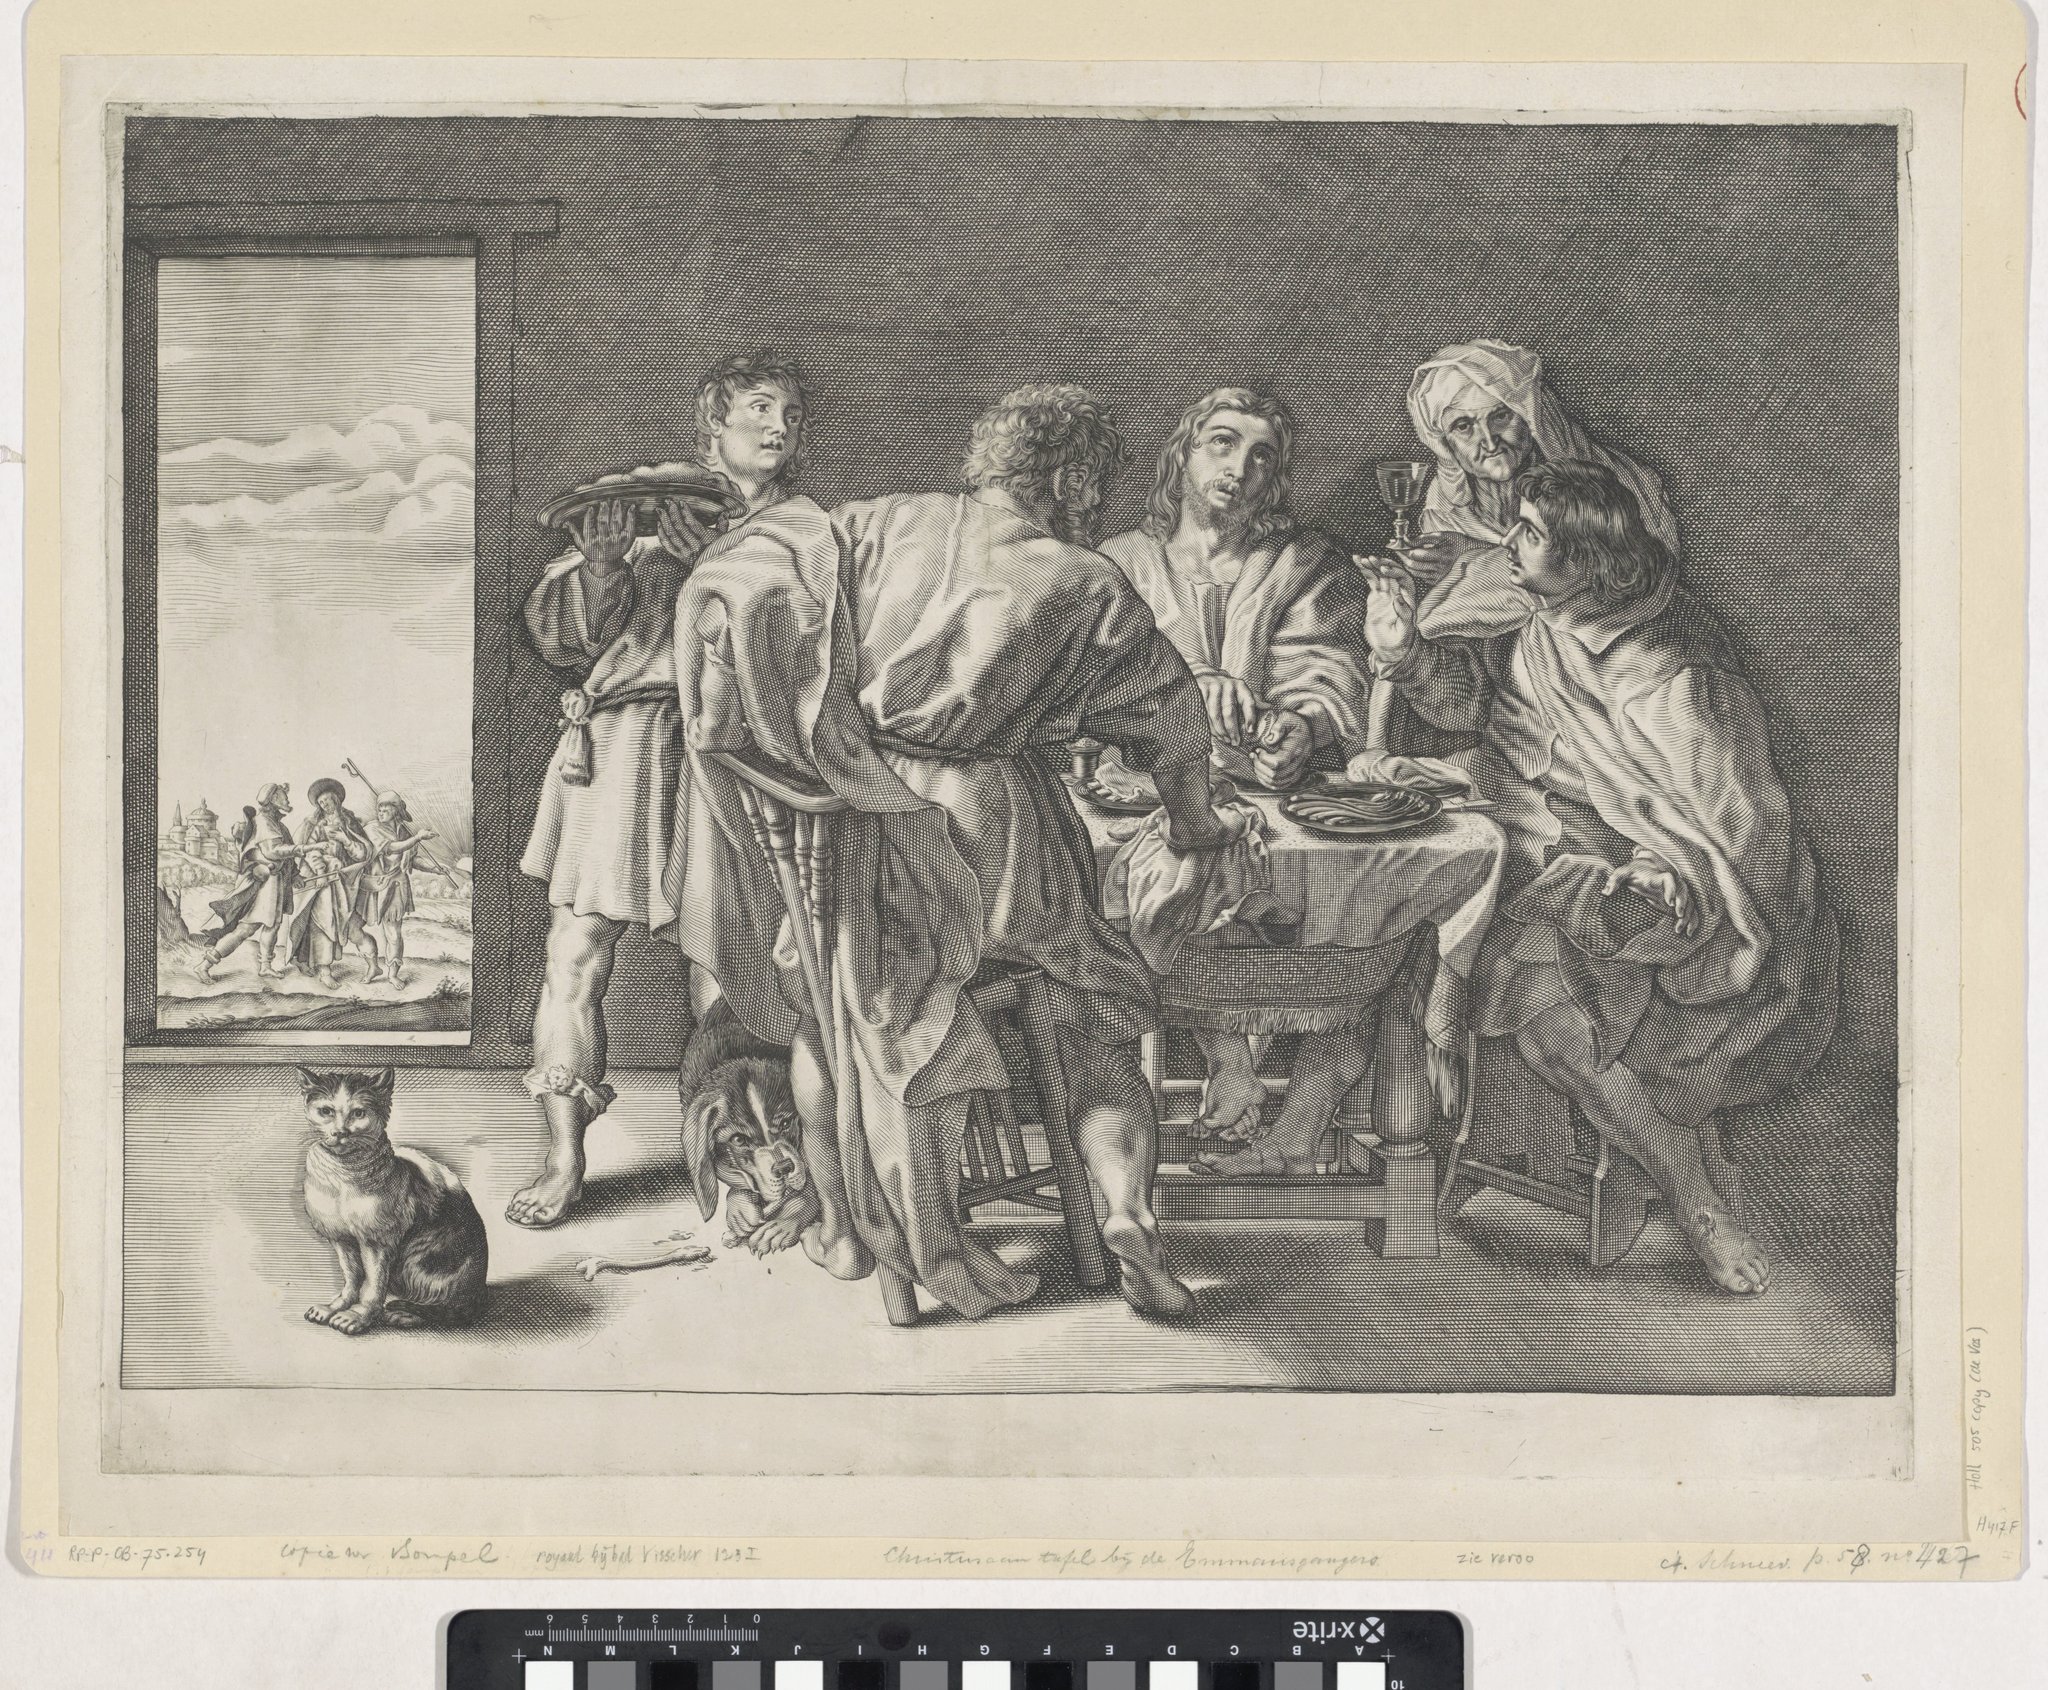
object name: print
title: Royaalbijbel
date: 1630-1652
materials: paper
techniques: engraving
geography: amsterdam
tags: the supper at emmaus: christ is recognized while blessing or breaking the bread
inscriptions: collector's mark: Lugt 240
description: De Amsterdamse uitgever Claes Jansz. Visscher (II) produceerde vanaf de jaren ’30 van de zeventiende eeuw grote Bijbelse prenten op zogenaamd royaal-formaat papier (ca. 480 x 580 mm). Na zijn dood in 1652 zette zijn zoon Nicolaes Visscher (I) het bedrijf voort en zo ook de uitgave van Royaalbijbelprenten. Toen Nicolaes in 1679 overleed nam zijn zoon Nicolaes Visscher (II) het bedrijf over en gaf kort hierna, omstreeks 1680, een fondslijst uit. Hierin worden 130 prenten met Bijbelse voorstellingen op royaalpapier beschreven (zie documentatie J. van der Waals). Complete prentbijbels op royaal-formaat werden door vader en zoon Nicolaes Visscher uitgegeven onder de titel Historiae Sacrae Veteris et Novi Testamenti. De bladen werden echter ook los verkocht en konden worden gecombineerd met Royaalbijbel-prenten van andere uitgevers. Verschillende Amsterdamse uitgevers brachten namelijk ook bijbelprenten op royaal-formaat uit, onder wie Clement de Jonghe en Cornelis Danckerts. De door de firma Visscher uitgegeven prenten zijn veelal vervaardigd door anonieme prentmakers naar voorbeeld van verschillende zestiende- en zeventiende-eeuwse Bijbelse prenten en prentreeksen. Veelal moesten de composities worden aangepast aan het grotere en langgerekte royaal-formaat. Daarnaast zijn er ook grote bladen van bekende prentmakers zoals Jan van Londerseel, Pieter Nolpe, Jacques de Gheyn (II) en Jan Harmensz. Muller opgenomen in de categorie ‘Bybelsche Figuren, op Royaal-bladen’ in de fondslijst van Visscher. Proefdruk voor de prent die is gebruikt in: Historiae Sacrae Veteris et Novi Testamenti (Royaalbijbel). Amsterdam: Nicolaes Visscher (I) en (II), [1652-1702]. In de fondslijst van Nicolaes Visscher II (ca. 1680) is het onderwerp van deze prent onder de titel 'Bybelsche Figuren, op Royaal-bladen. bestaande uyt de volgende historien.' als volgt genummerd: 123. De voorstelling van de maaltijd in Emmaüs naar een prent van Swanenburg of Van Sompel naar een schilderij van Rubens. De Emmaüsgangers in de deuropening naar een prent van Goltzius naar ontwerp van de Vos.